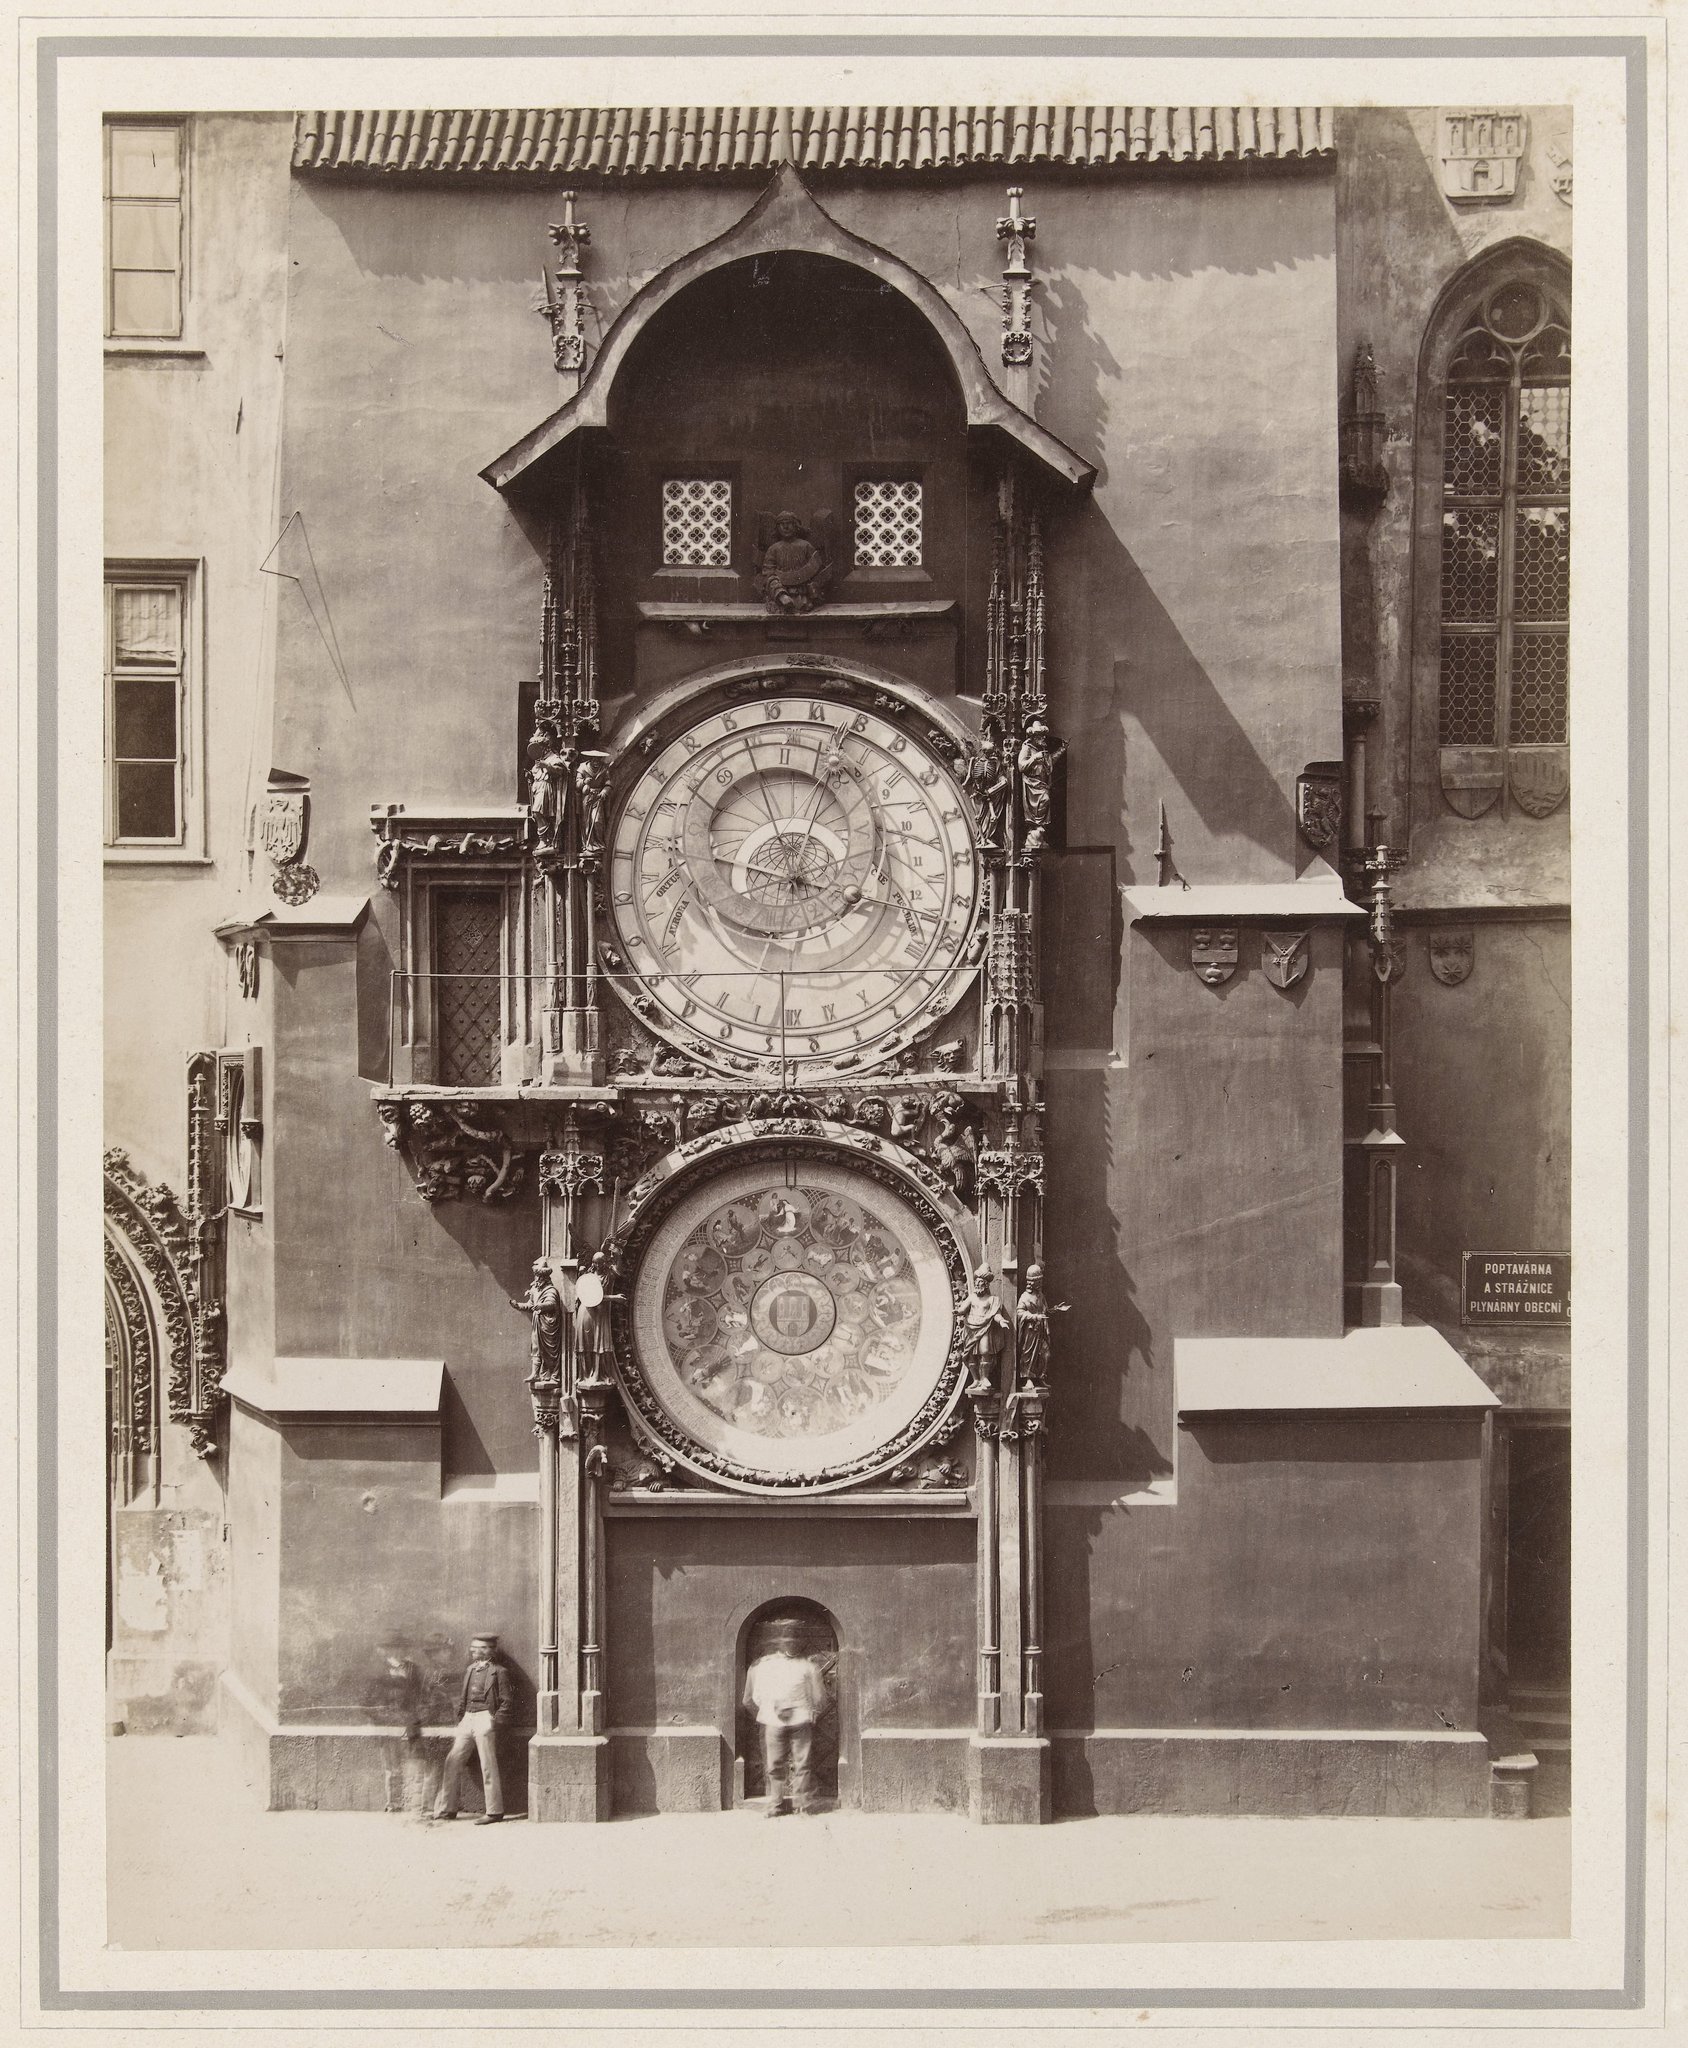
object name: photograph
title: Astronomische Uhr am Altst. Rathhause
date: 1855-1900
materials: cardboard, paper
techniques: albumen print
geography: prague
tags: clock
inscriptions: number: ‘71.’